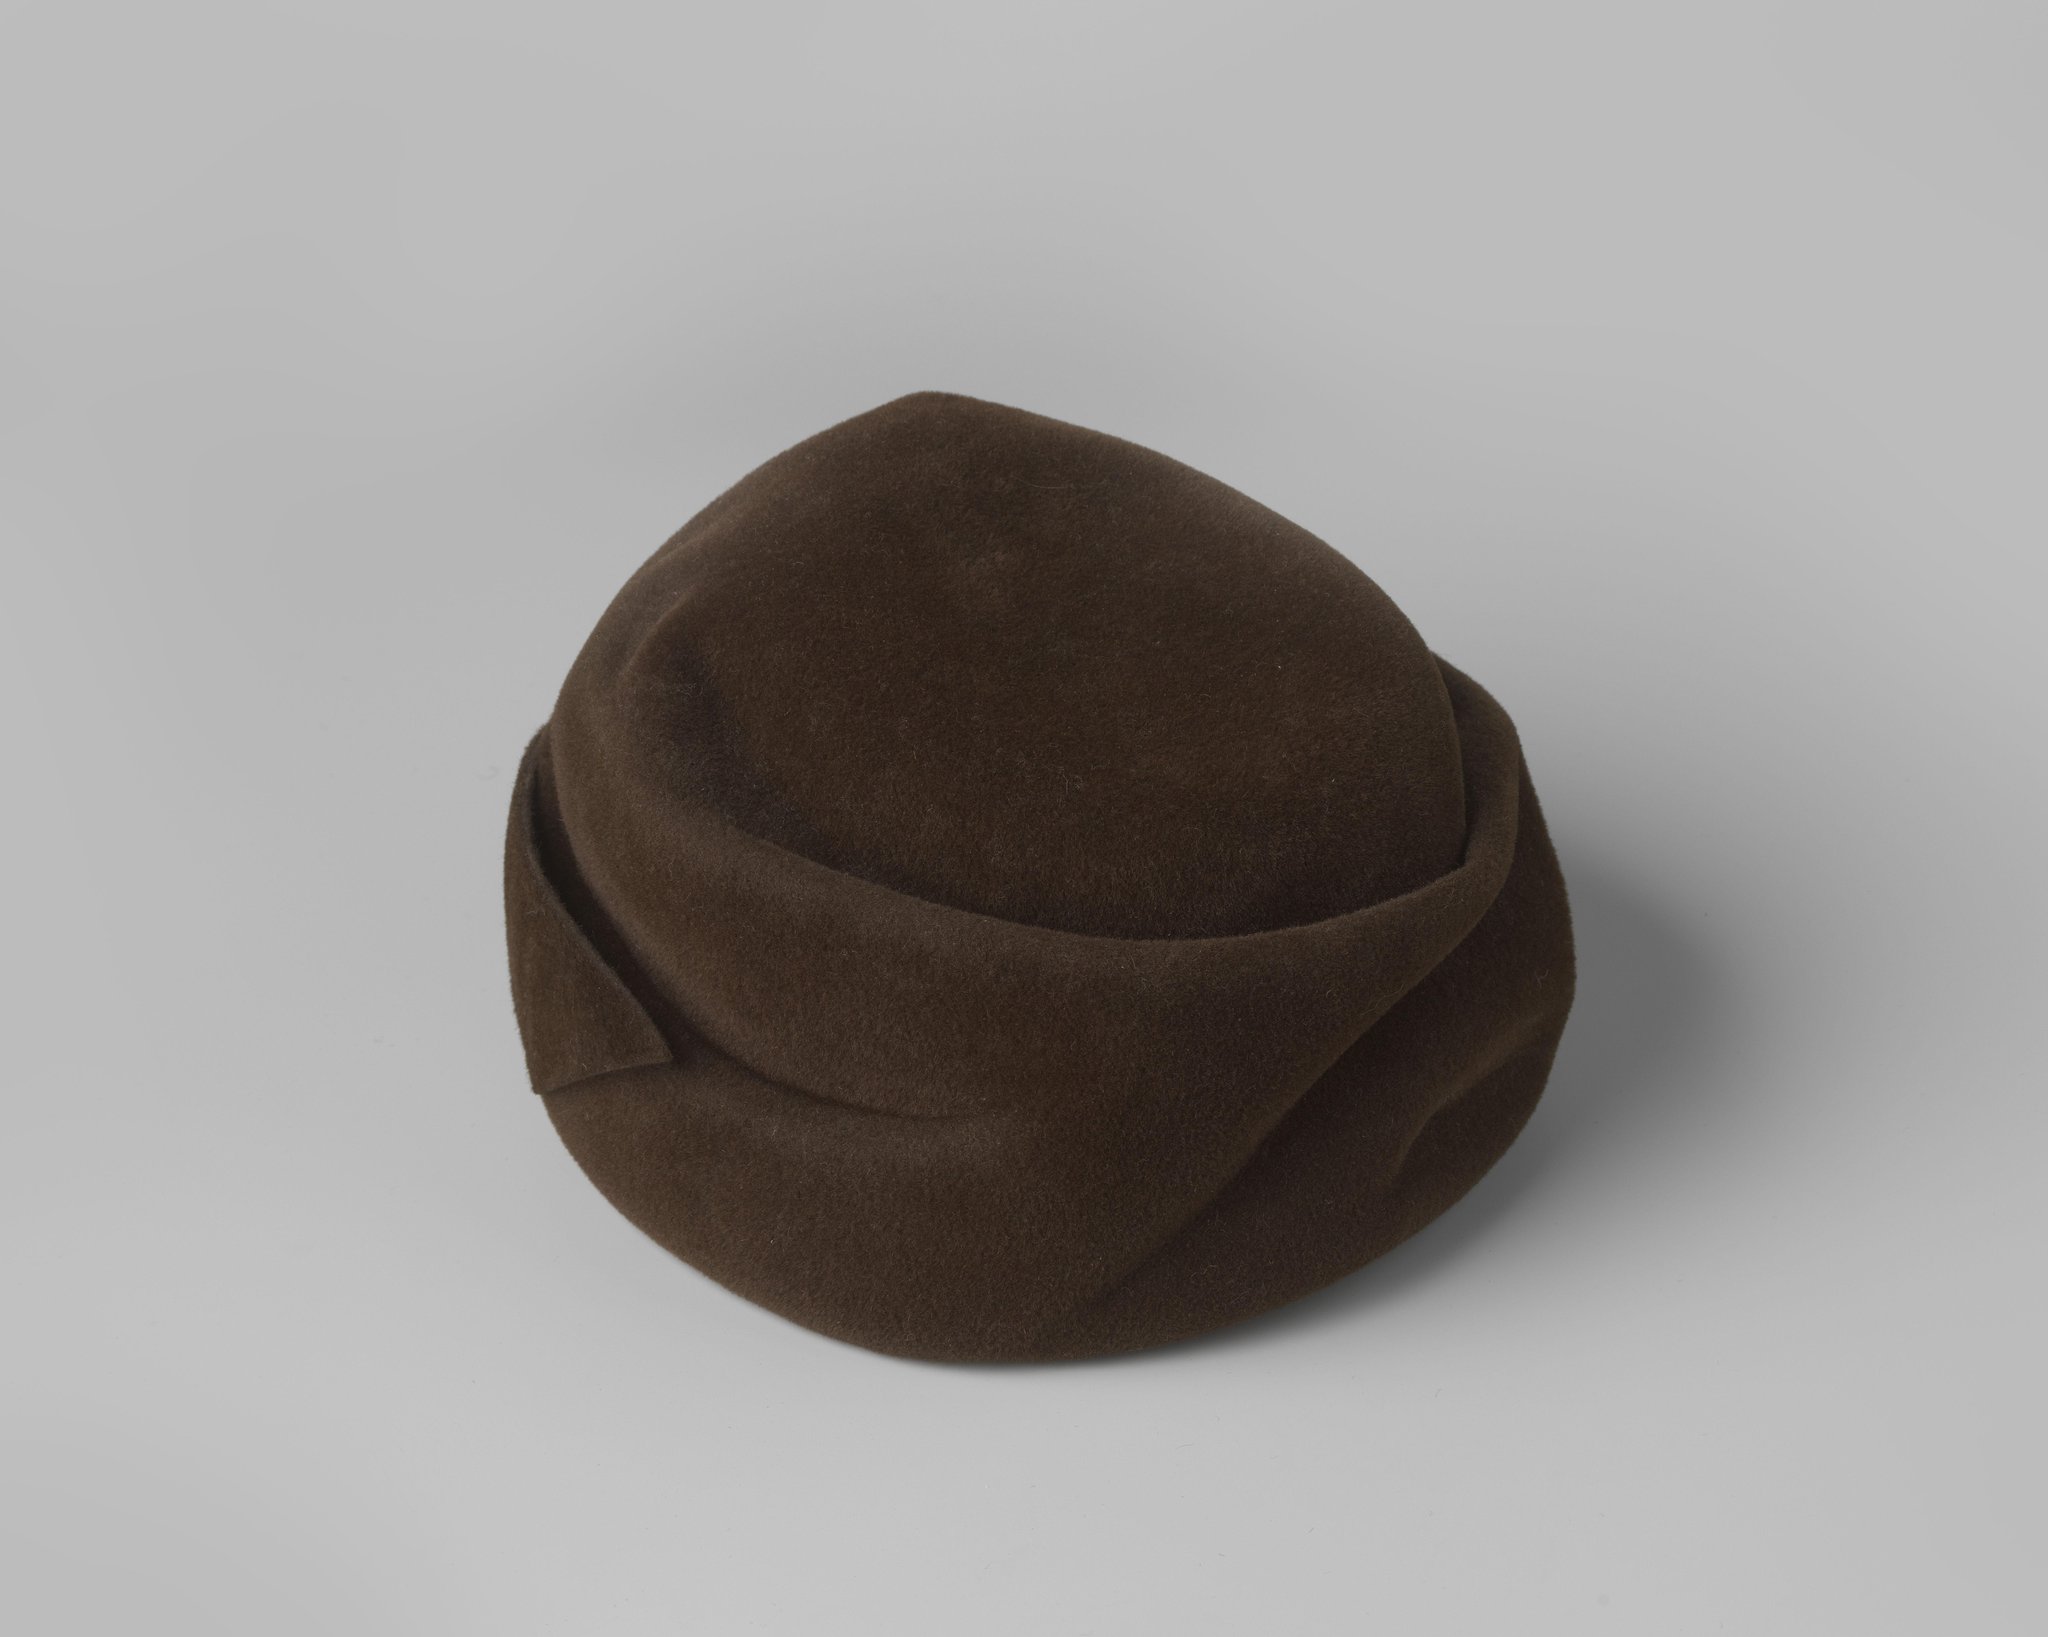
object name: womenswear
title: Hoed van bruin vilt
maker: t.c.c.m. hoogland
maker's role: hoedenmaker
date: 1956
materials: felt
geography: utrecht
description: Hoed van bruin vilt. Het toque model met plooi is versierd met een schuin afgeknipte strook vilt.